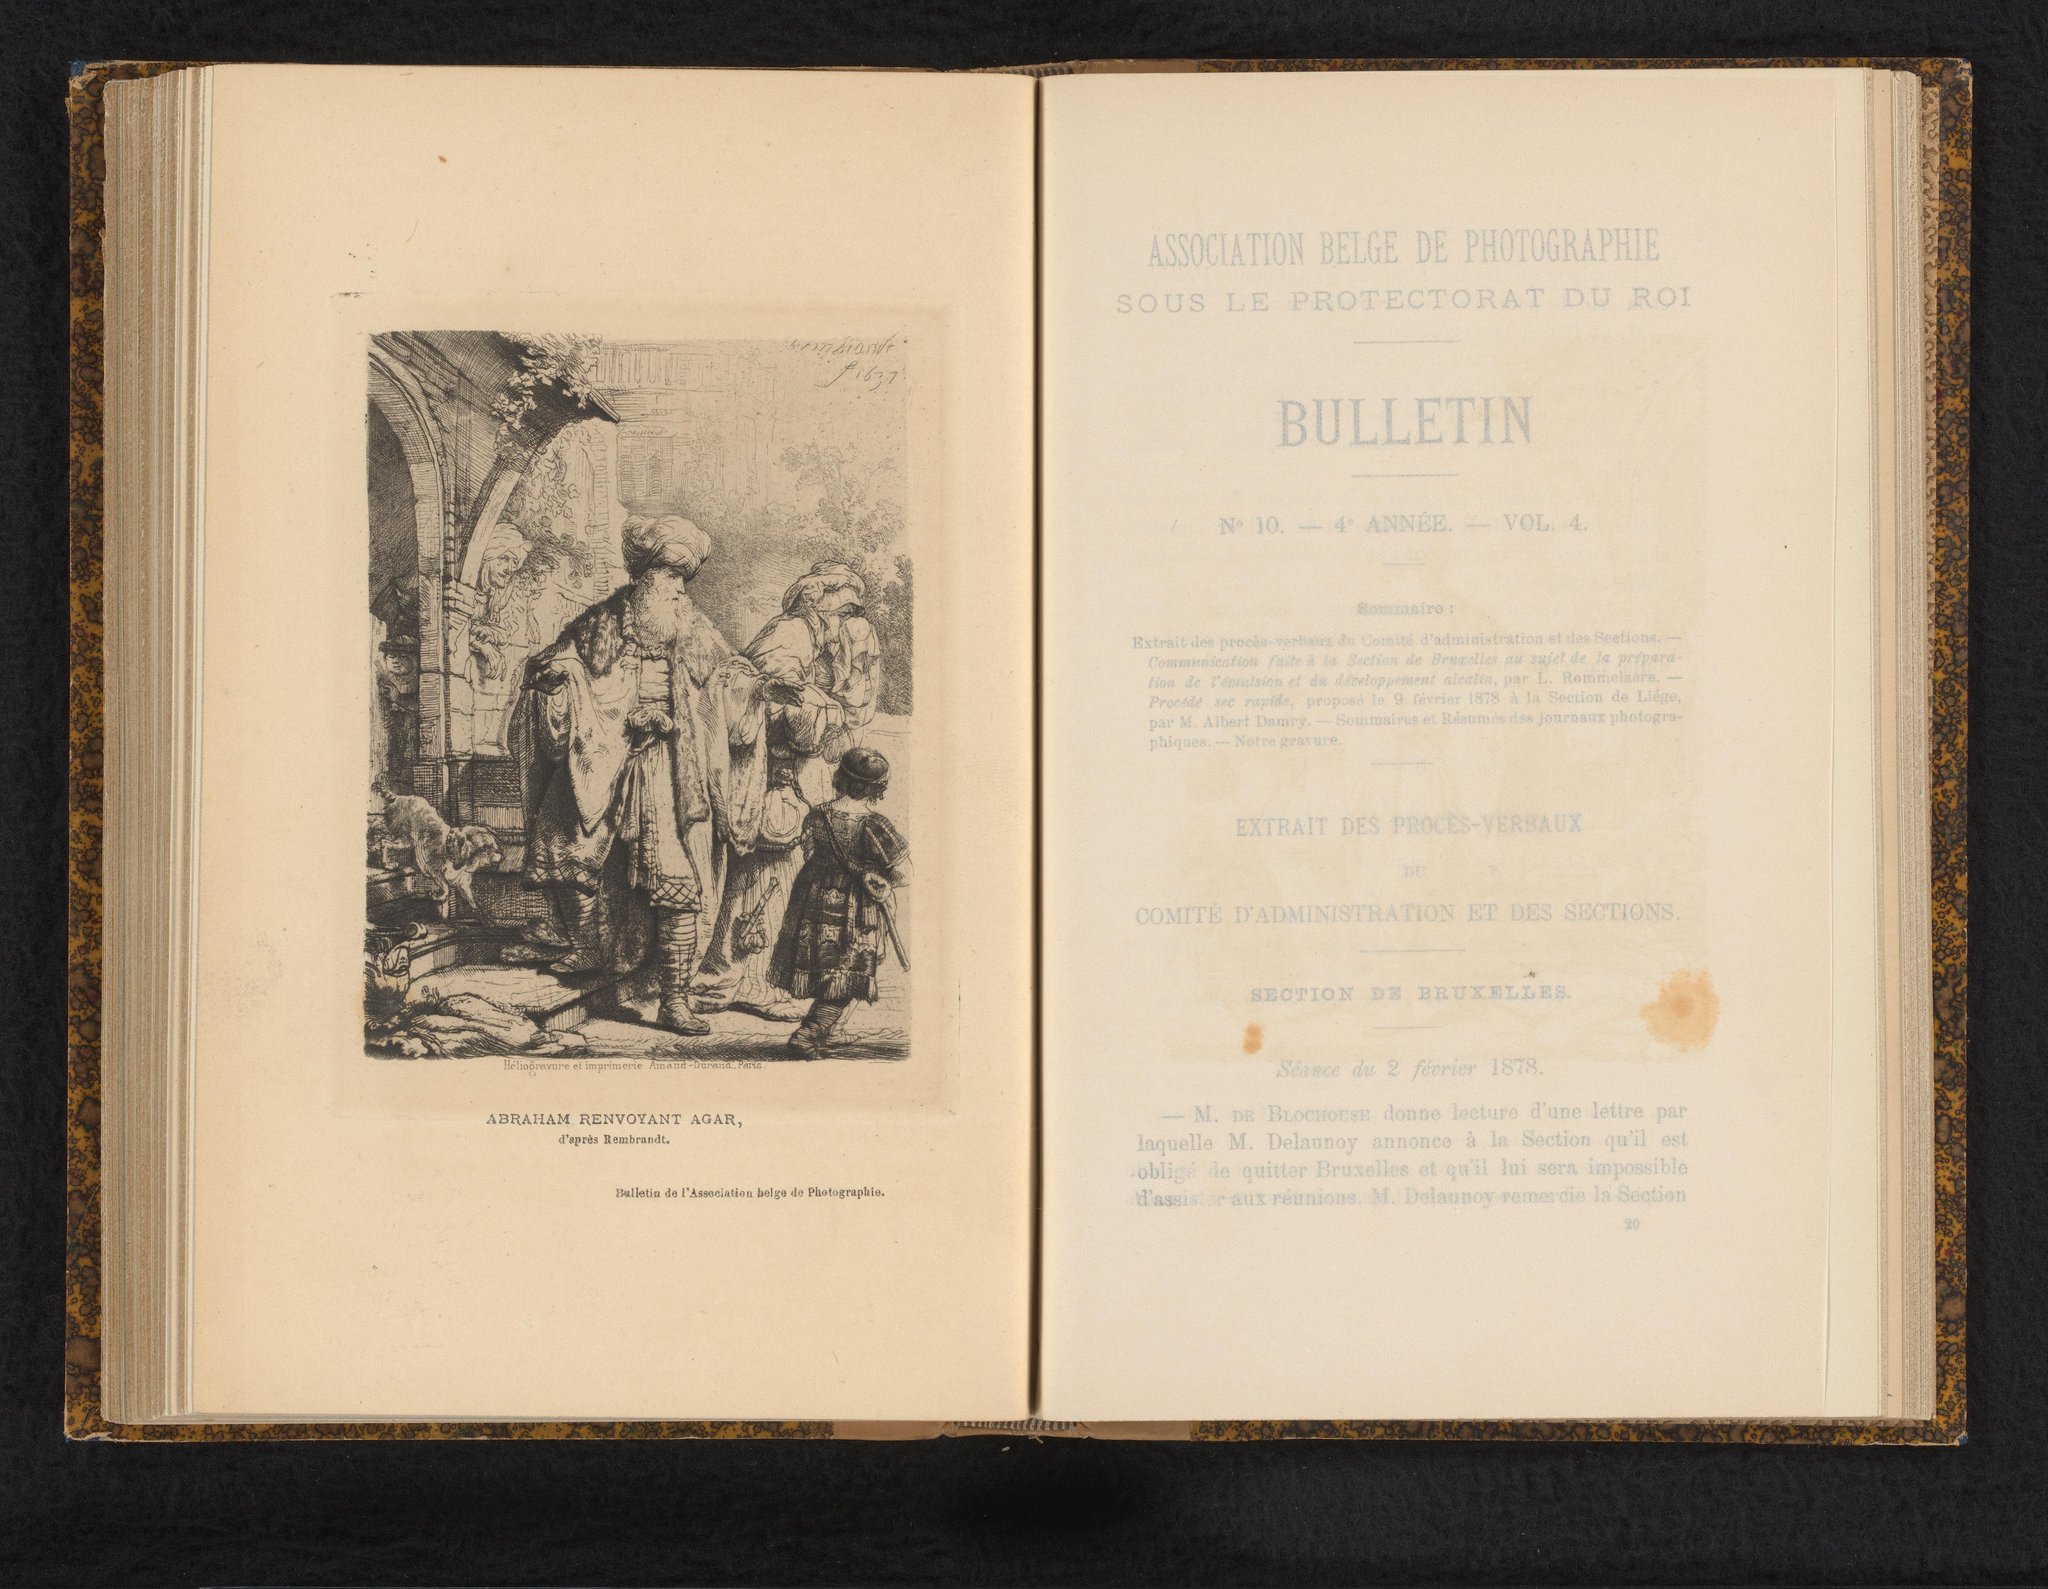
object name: page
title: Reproductie van de ets Abraham verstoot Hagar en Ismaël door Rembrandt van Rijn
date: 1877-1878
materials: paper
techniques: photoaquatint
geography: paris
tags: the banishment of hagar and ishmael (genesis 21:9-21)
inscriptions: inscription: ‘Héliogravure et imprimerie Amand-Durand Paris’